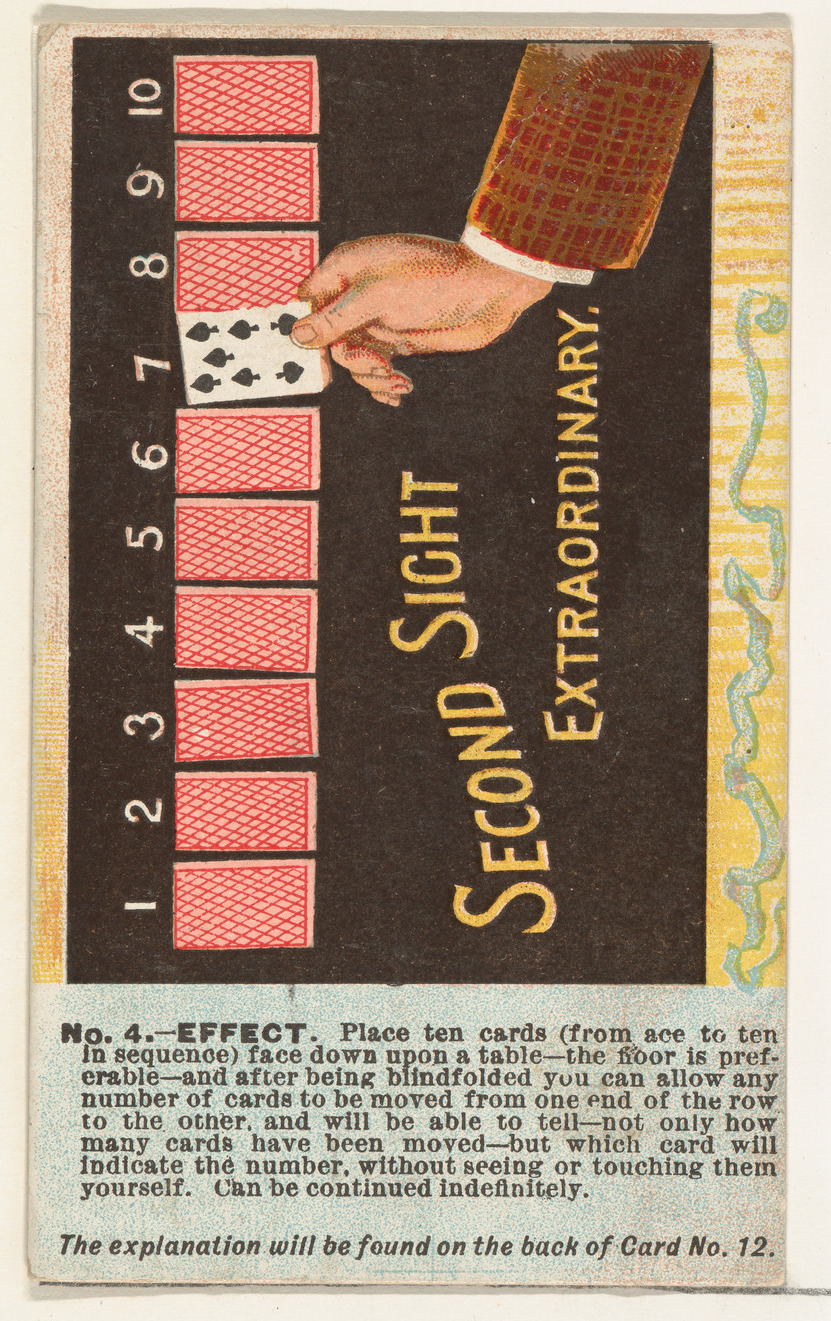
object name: print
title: Number 4, Second Sight Extraordinary, from the Tricks with Cards series (N138) issued by W. Duke, Sons & Co. to promote Honest Long Cut Tobacco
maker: w. duke, sons & co.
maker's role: publisher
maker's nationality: american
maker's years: 1870-1920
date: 1887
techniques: color lithograph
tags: magic,playing cards